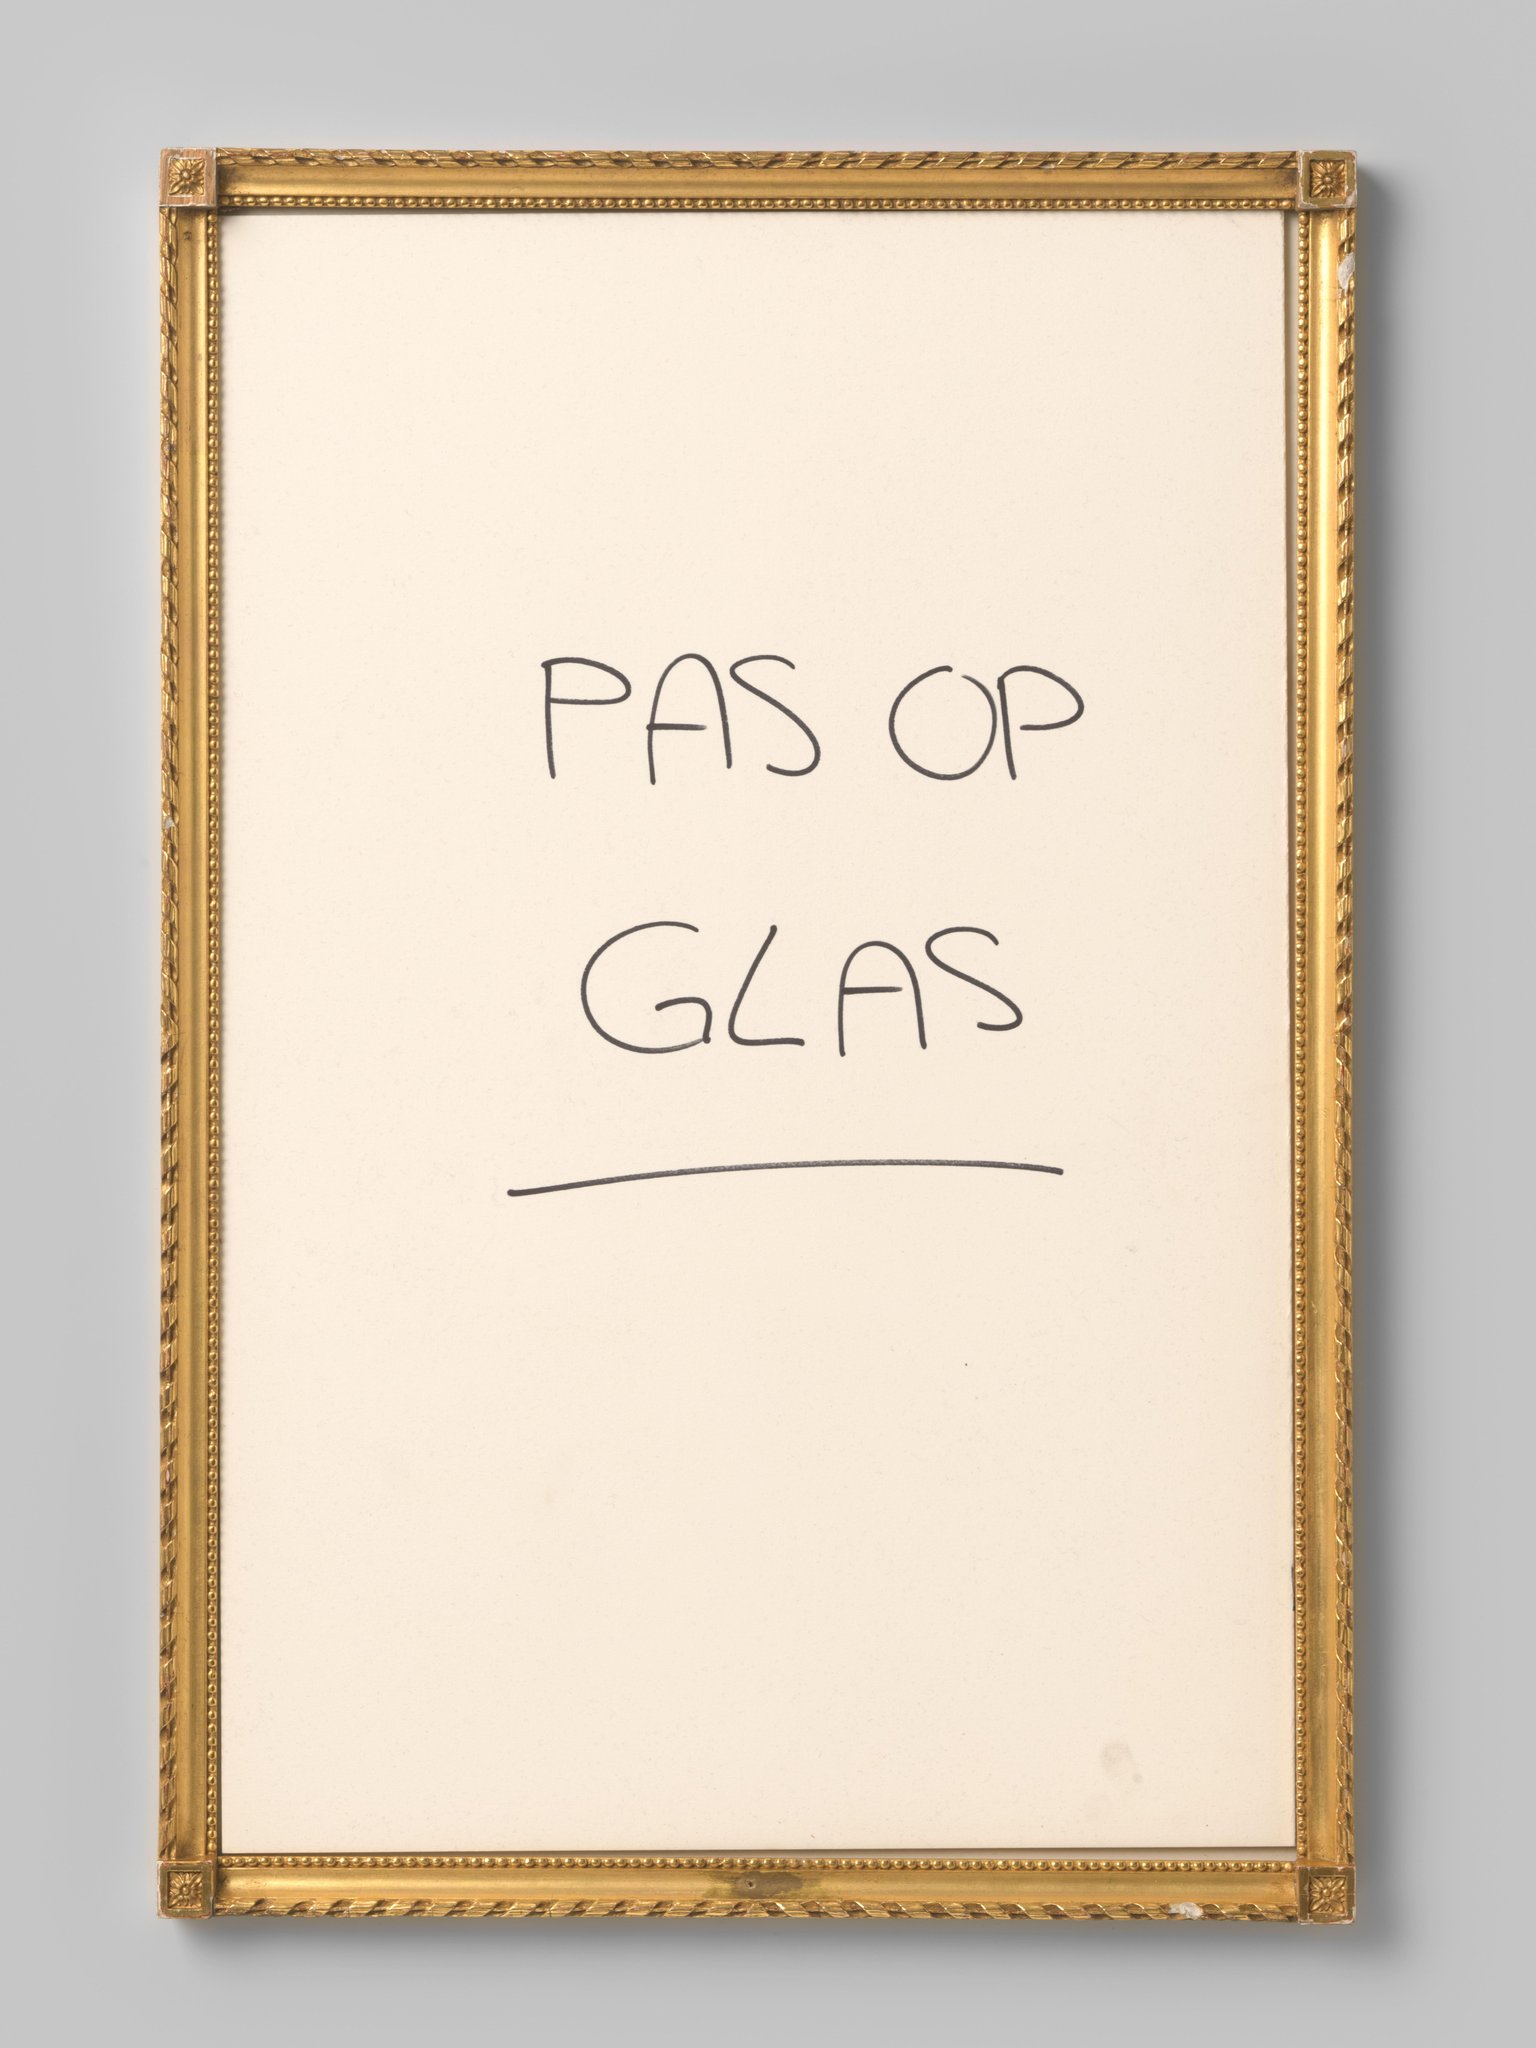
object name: frame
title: Smalle vergulde lijst met pâte-ornamenten in classicistische stijl.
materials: gold leaf, wood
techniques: gilding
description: Goudkleurige houten lijst met spiraalmotief en parelrand en op de hoeken een bloemmotief.